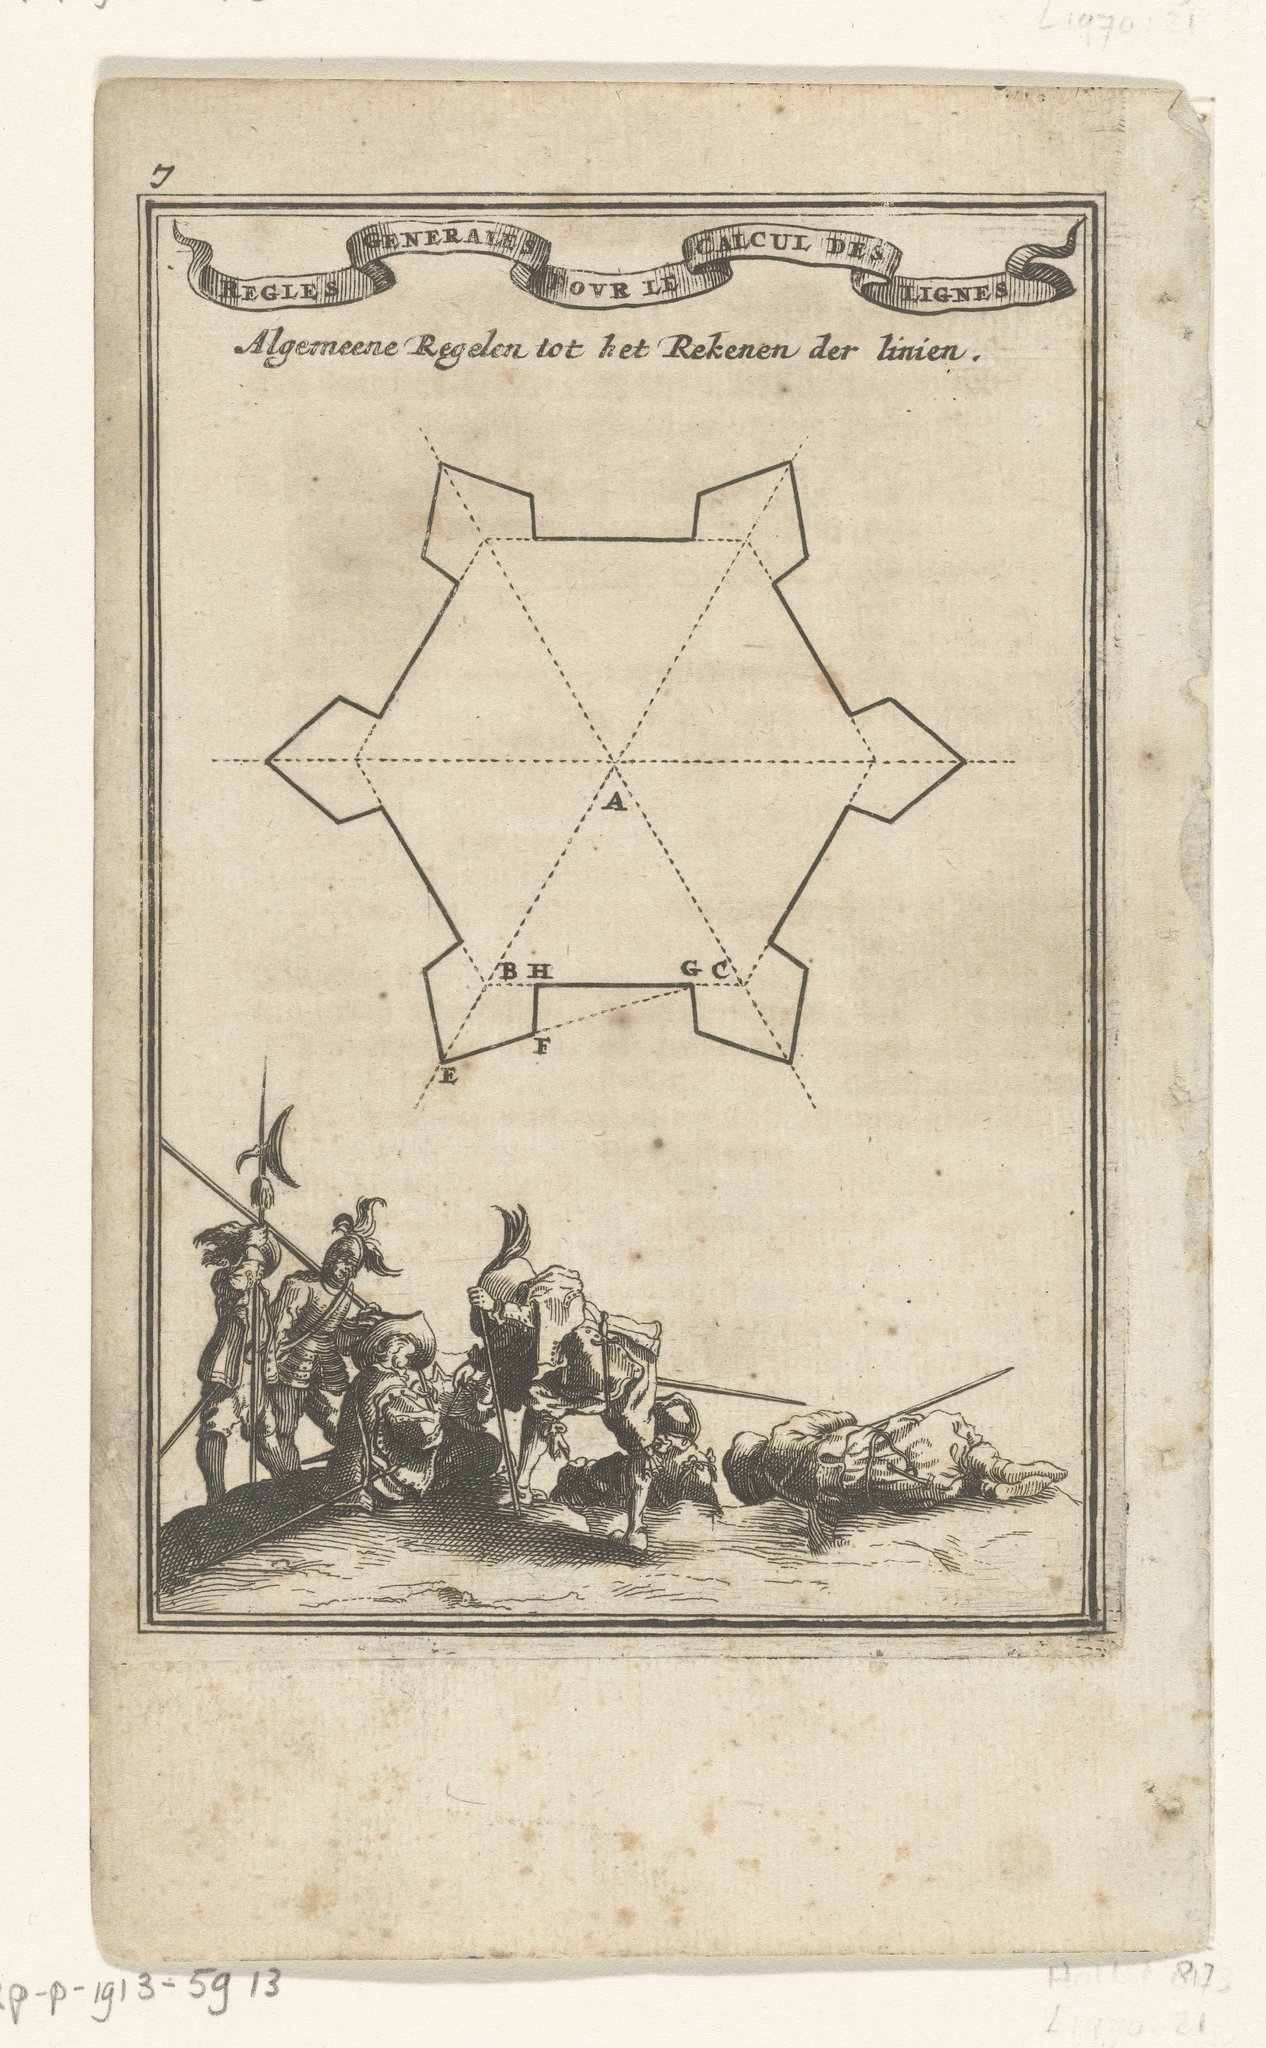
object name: book illustration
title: Illustratie voor 'Den Arbeid van Mars' van Allain Manesson Mallet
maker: romeyn de hooghe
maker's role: draughtsman, goldsmith, painter, print maker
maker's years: 1645-1708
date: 1672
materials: paper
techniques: engraving, etching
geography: amsterdam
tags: fortifications, military engineering, the soldier; the soldier's life, mathematics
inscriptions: collector's mark: Lugt 2228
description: Grondplan voor een vesting, fort of versterking (zeshoek). Daaronder vij soldaten rond een zesde die iets opschrijft of uittekent. In de hoek linksboven het cijfer 7 (= het nummer van de pagina in het boek waartegenover de illustratie geplaatst is).